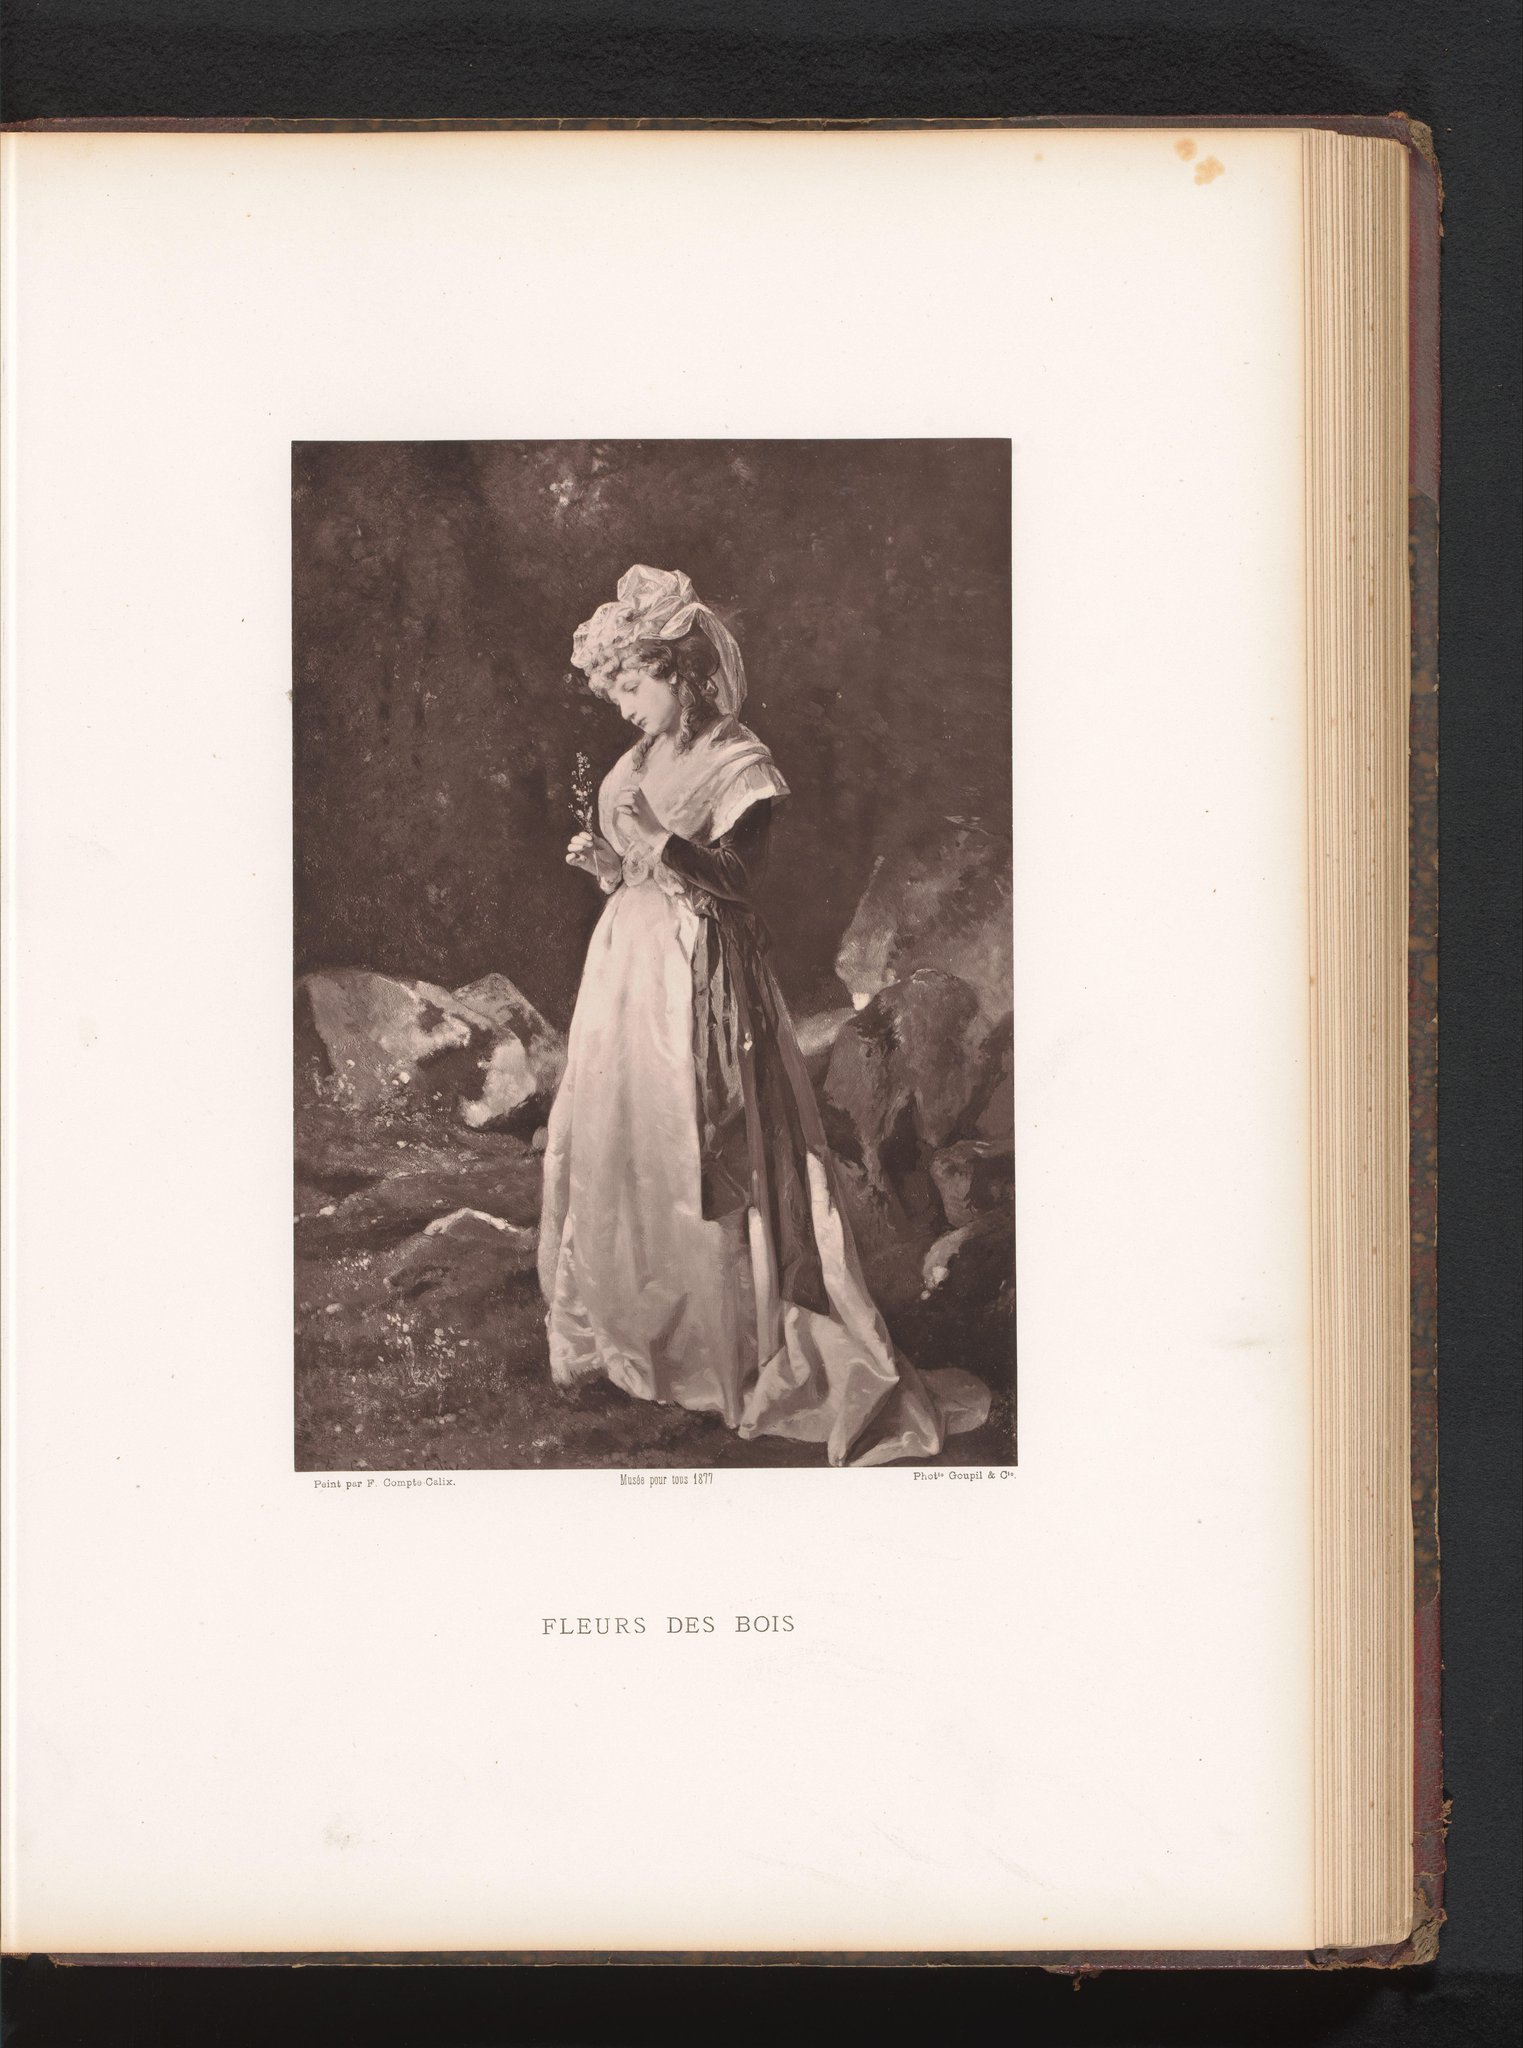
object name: photomechanical print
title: Reproductie van een schilderij van een meisje met een wilde bloem door François-Claudius Compte-Calix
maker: françois-claudius compte-calix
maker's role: draughtsman, painter, print maker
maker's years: 1813-1880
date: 1872-1879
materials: paper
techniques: woodburytype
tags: picking flowers, girl (child between toddler and youth)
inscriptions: inscription: ‘Musée pour tous 1877’